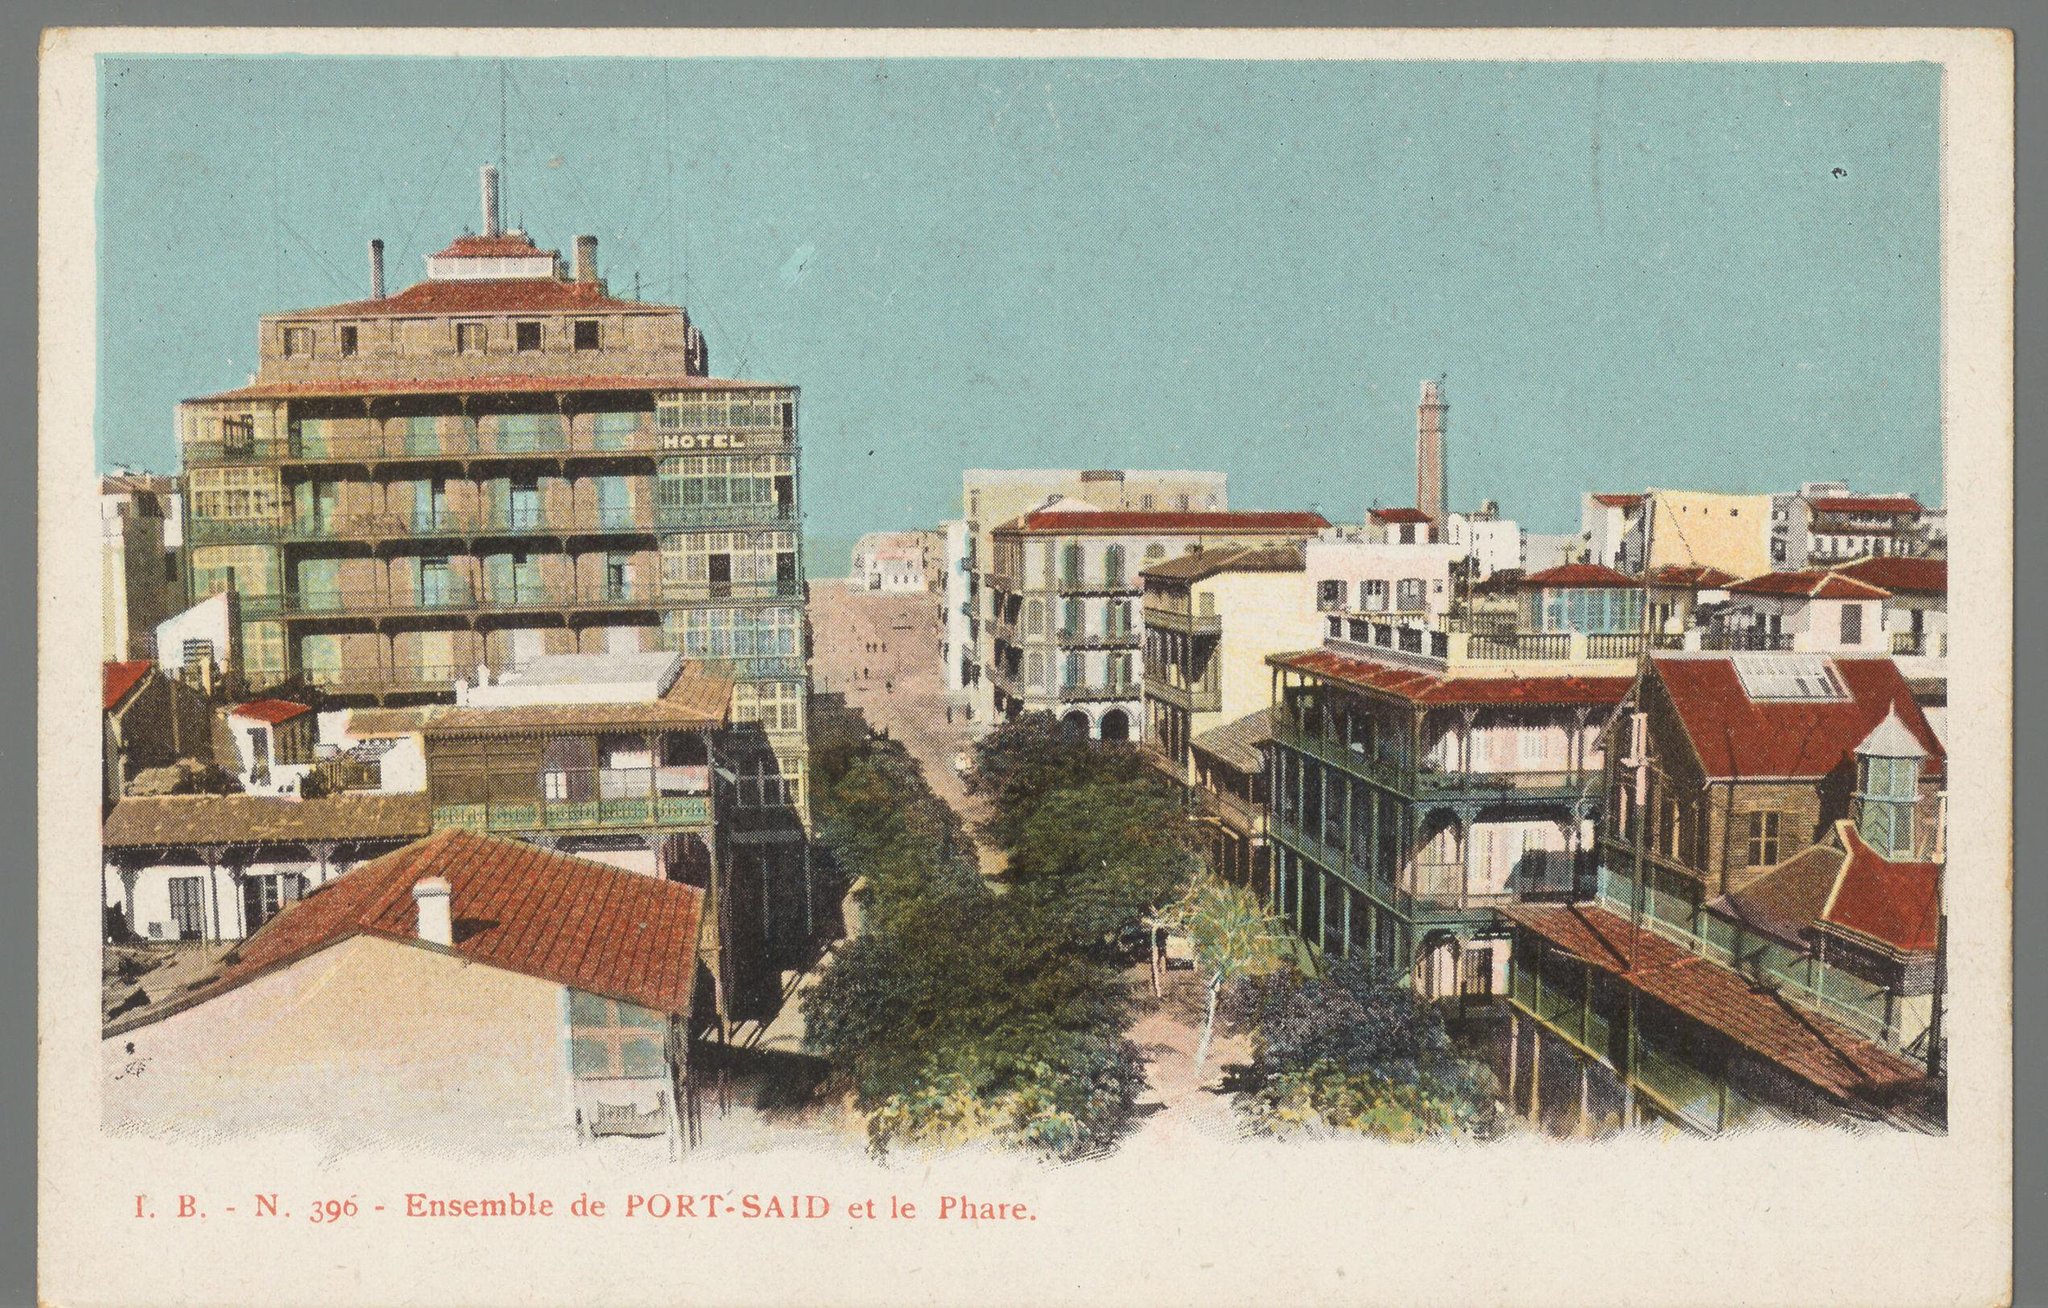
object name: photomechanical print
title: Ensemble de Port-Said et le Phare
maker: Anonymous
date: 1907-1930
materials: cardboard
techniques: lithograph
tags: lighthouse, lightship, street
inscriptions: monogram: ‘AG’, inscription: ‘I. B. - N.’